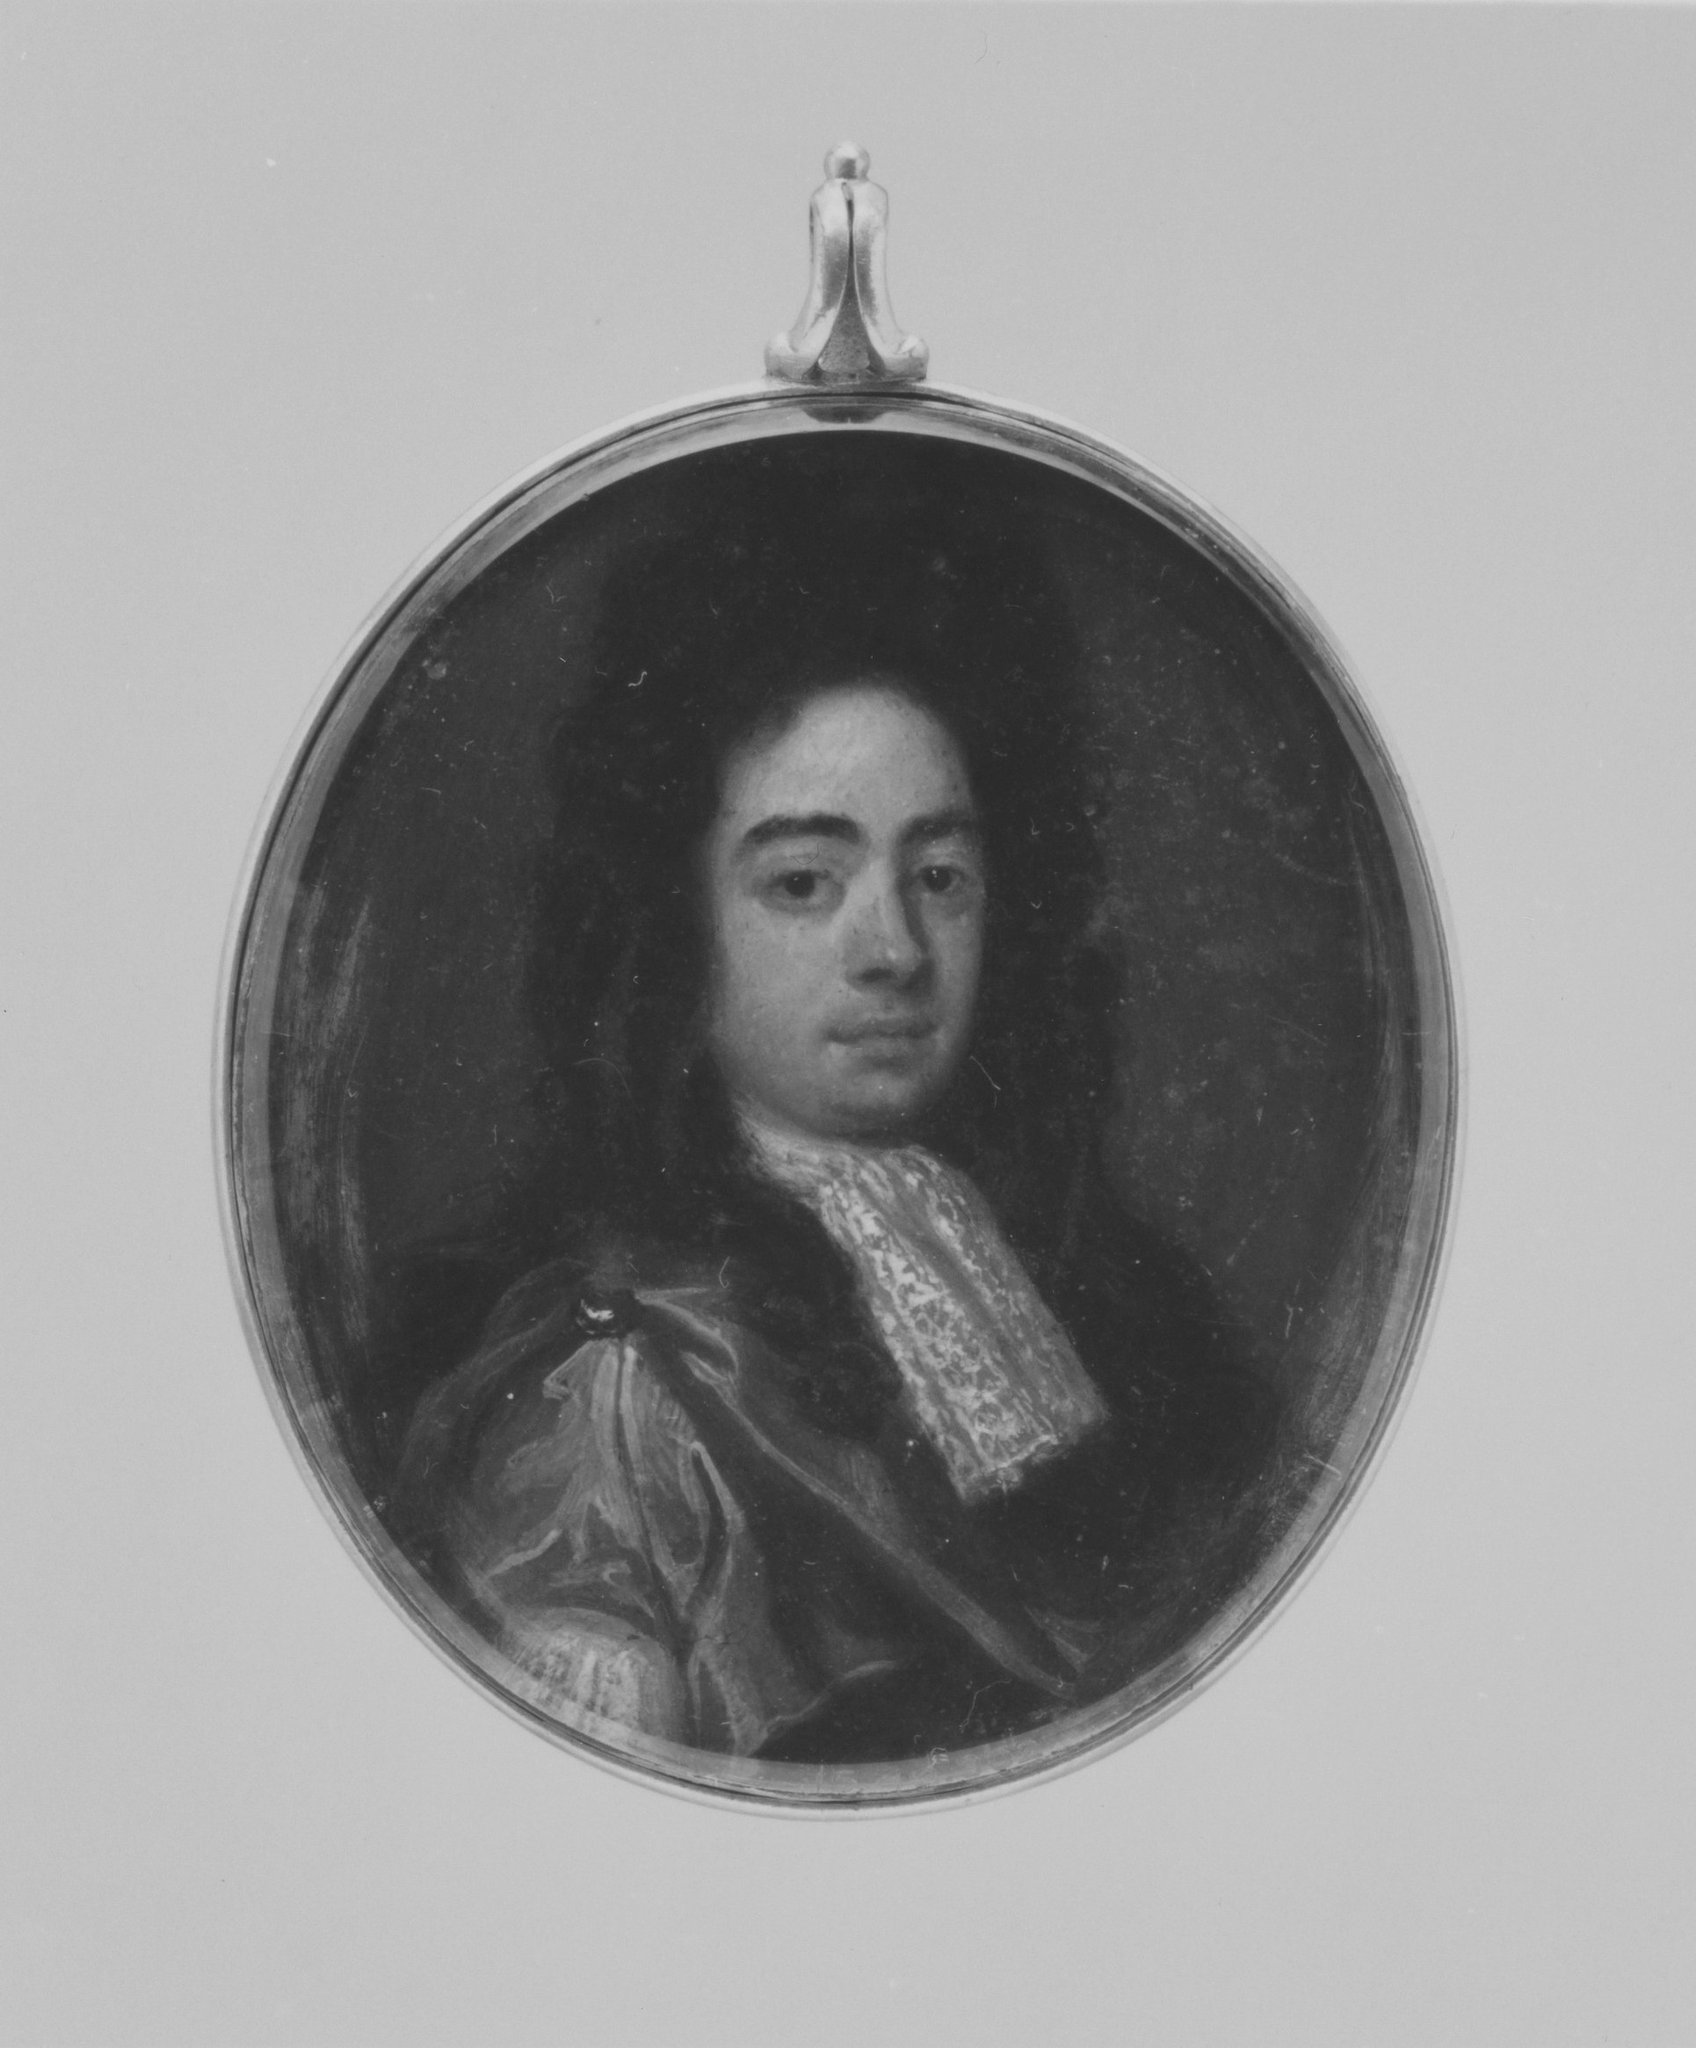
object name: painting, miniature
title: Portrait of a Man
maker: british painter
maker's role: artist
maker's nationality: british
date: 1685-1695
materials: copper, oil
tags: men,portraits